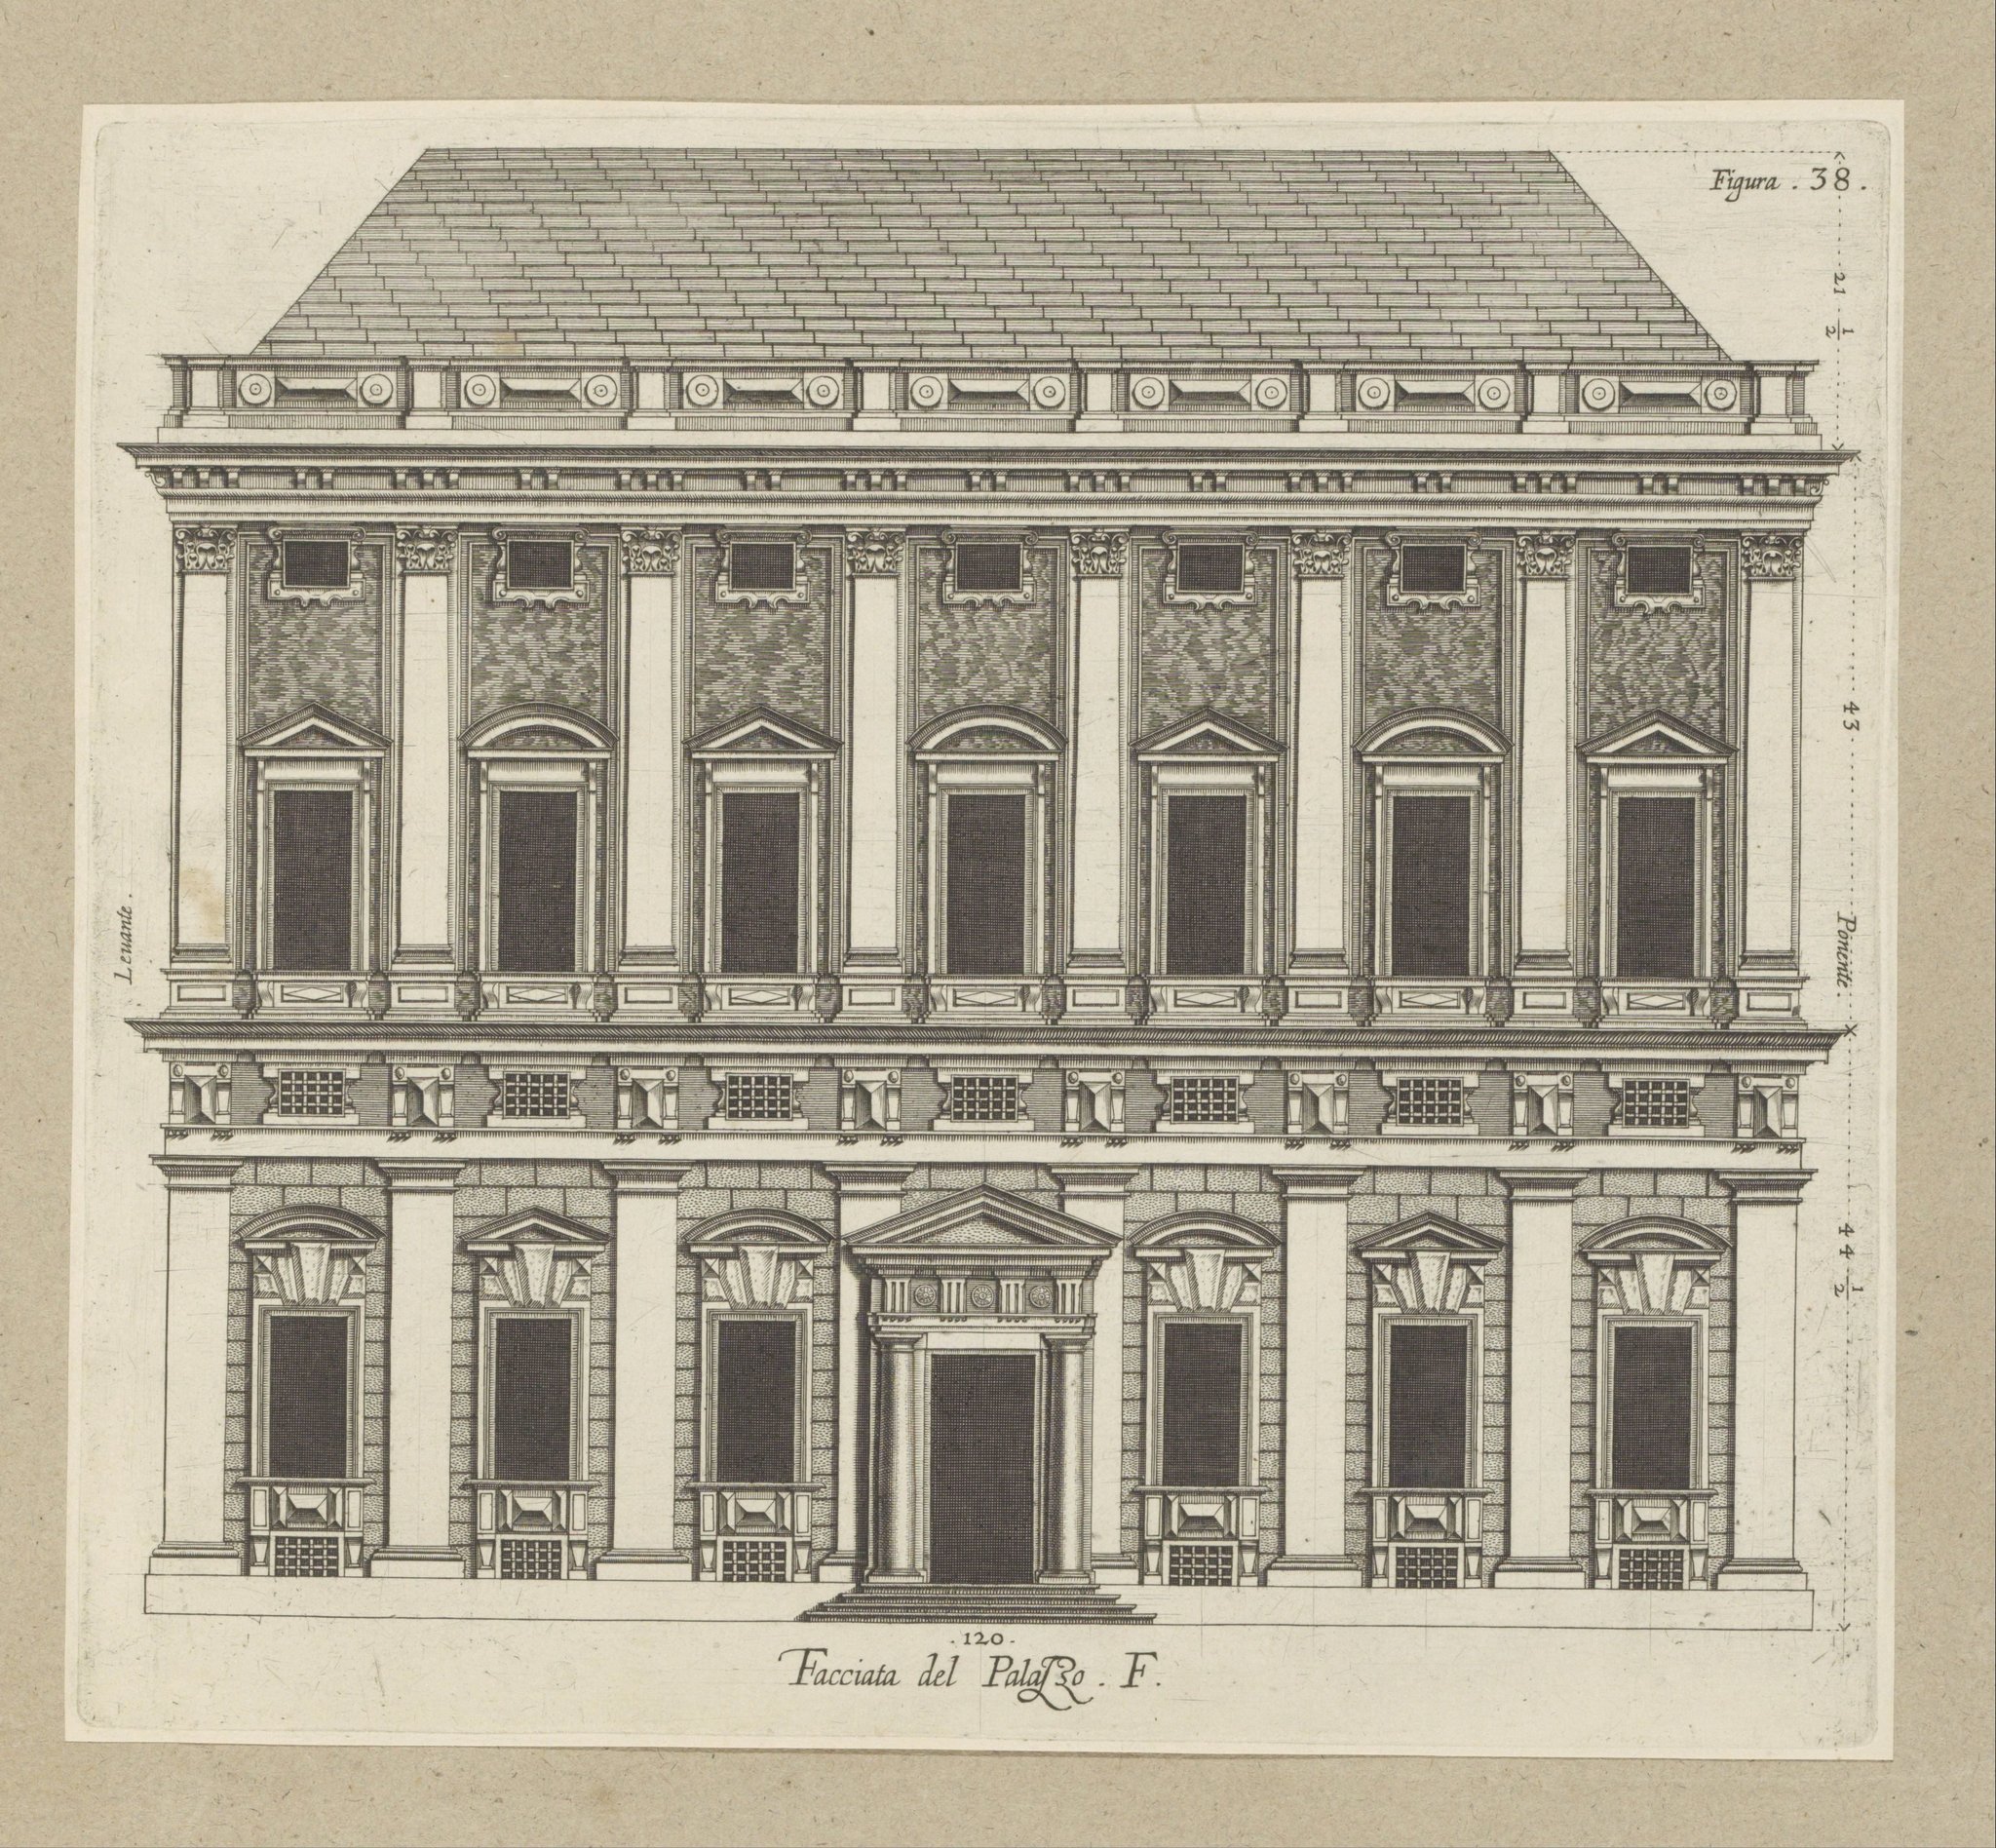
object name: print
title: Facciata del Palazzo. F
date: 1622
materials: paper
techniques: engraving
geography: antwerp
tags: hôtel, i.e. small palace in city, exterior ~ architectural design or model, front façade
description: Deze prent maakt deel uit van een album.